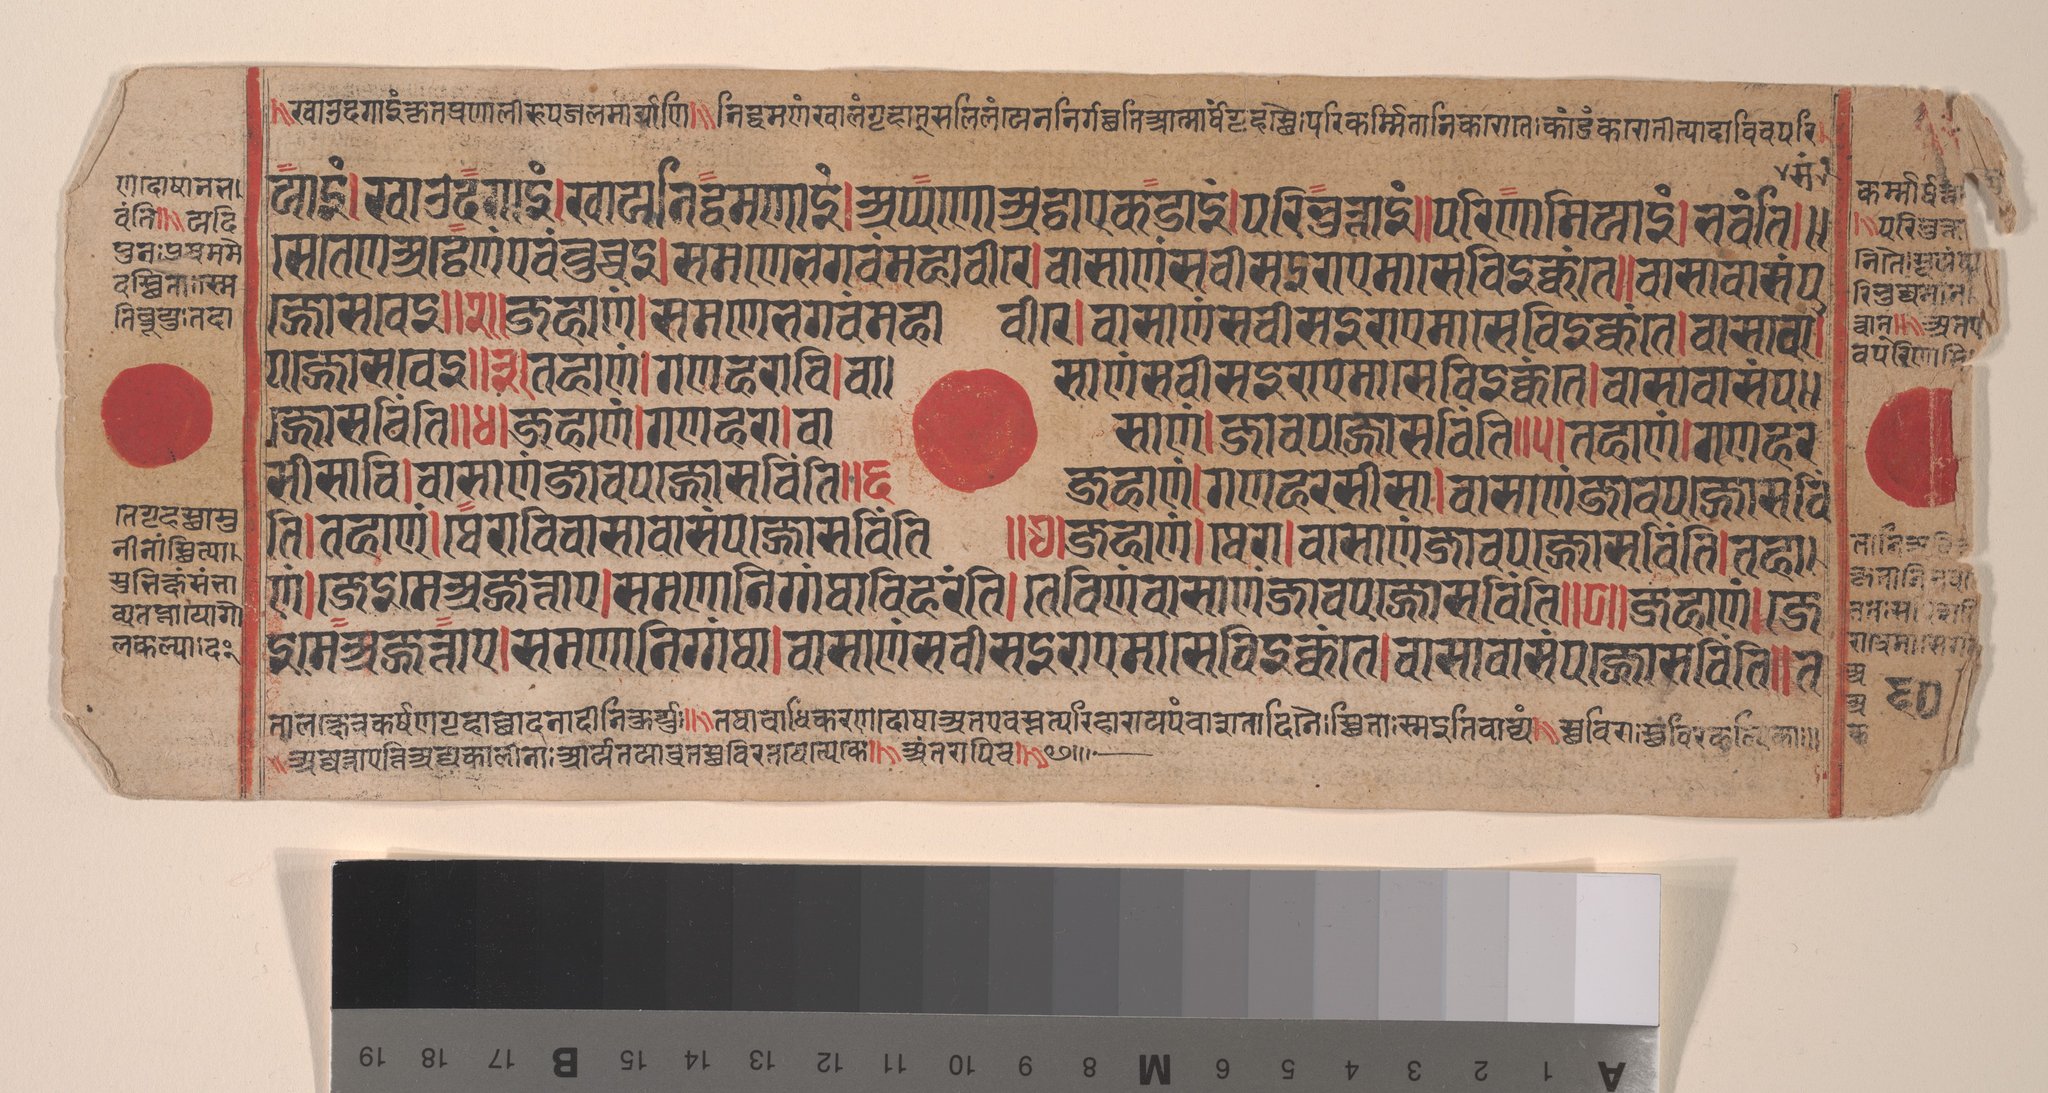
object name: folio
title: Leaf from a Kalpa Sutra (Jain Book of Rituals)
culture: indian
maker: bhadrabahu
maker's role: artist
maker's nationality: indian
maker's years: 356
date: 1401-1500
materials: gold, ink, paper, watercolor